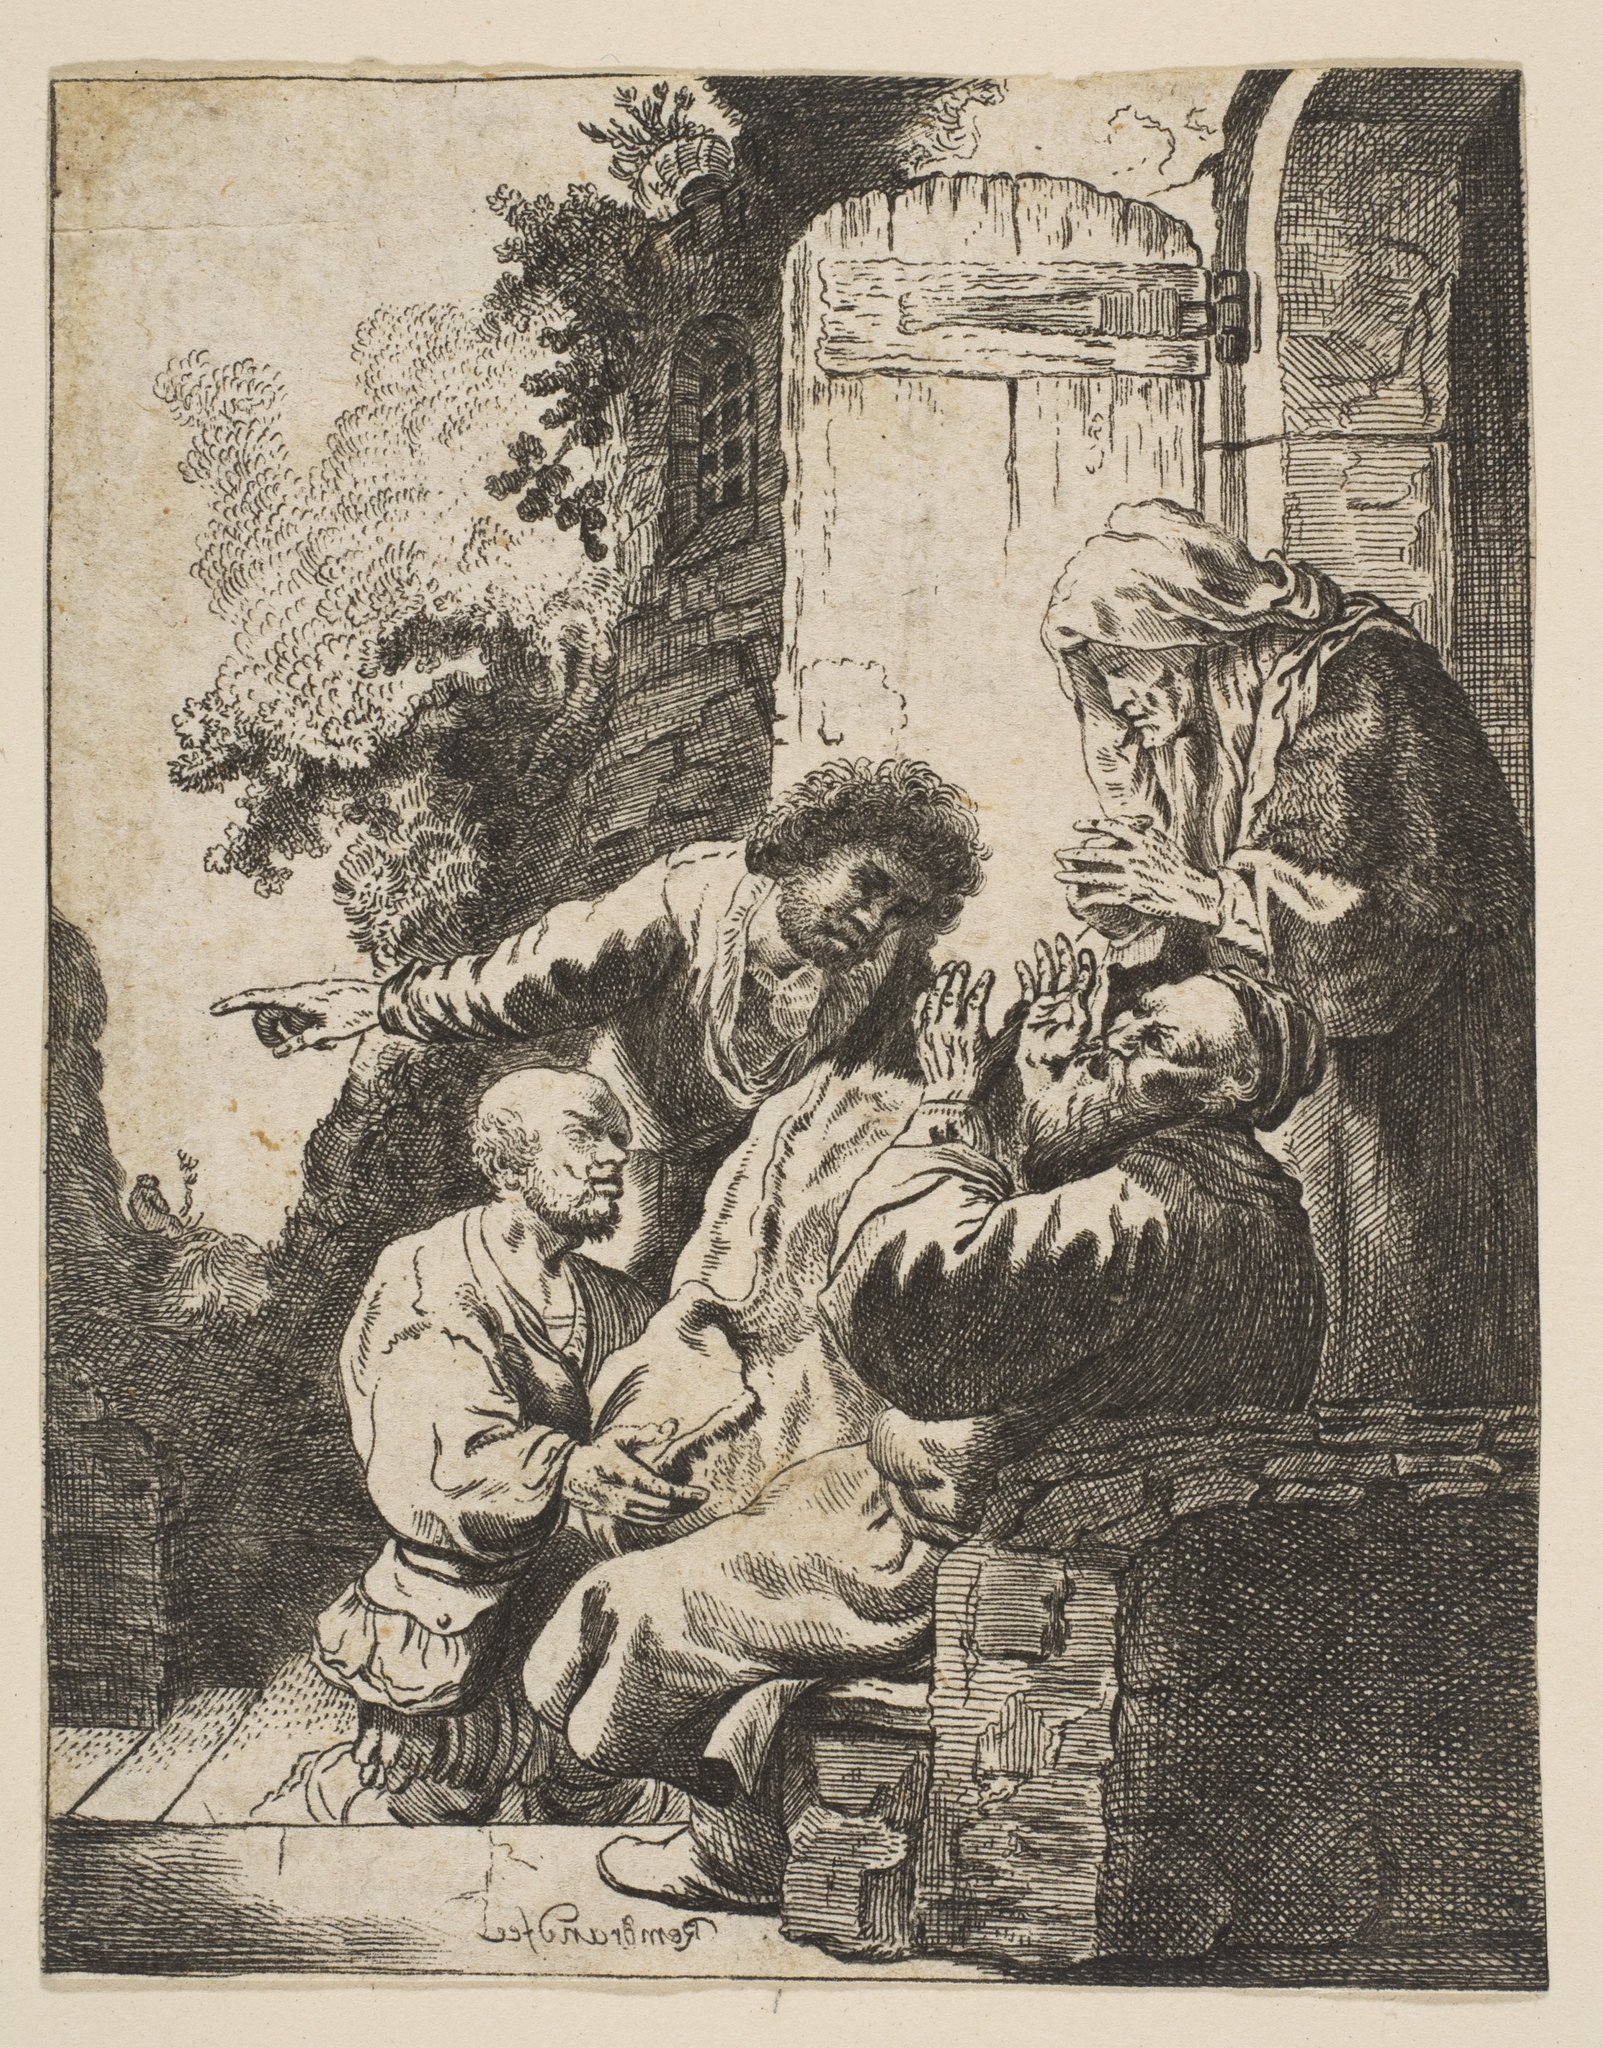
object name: print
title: Joseph's Coat Brought to Jacob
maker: johann georg hertel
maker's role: artist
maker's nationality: german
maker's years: 1695-1775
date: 1633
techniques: etching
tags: men,women